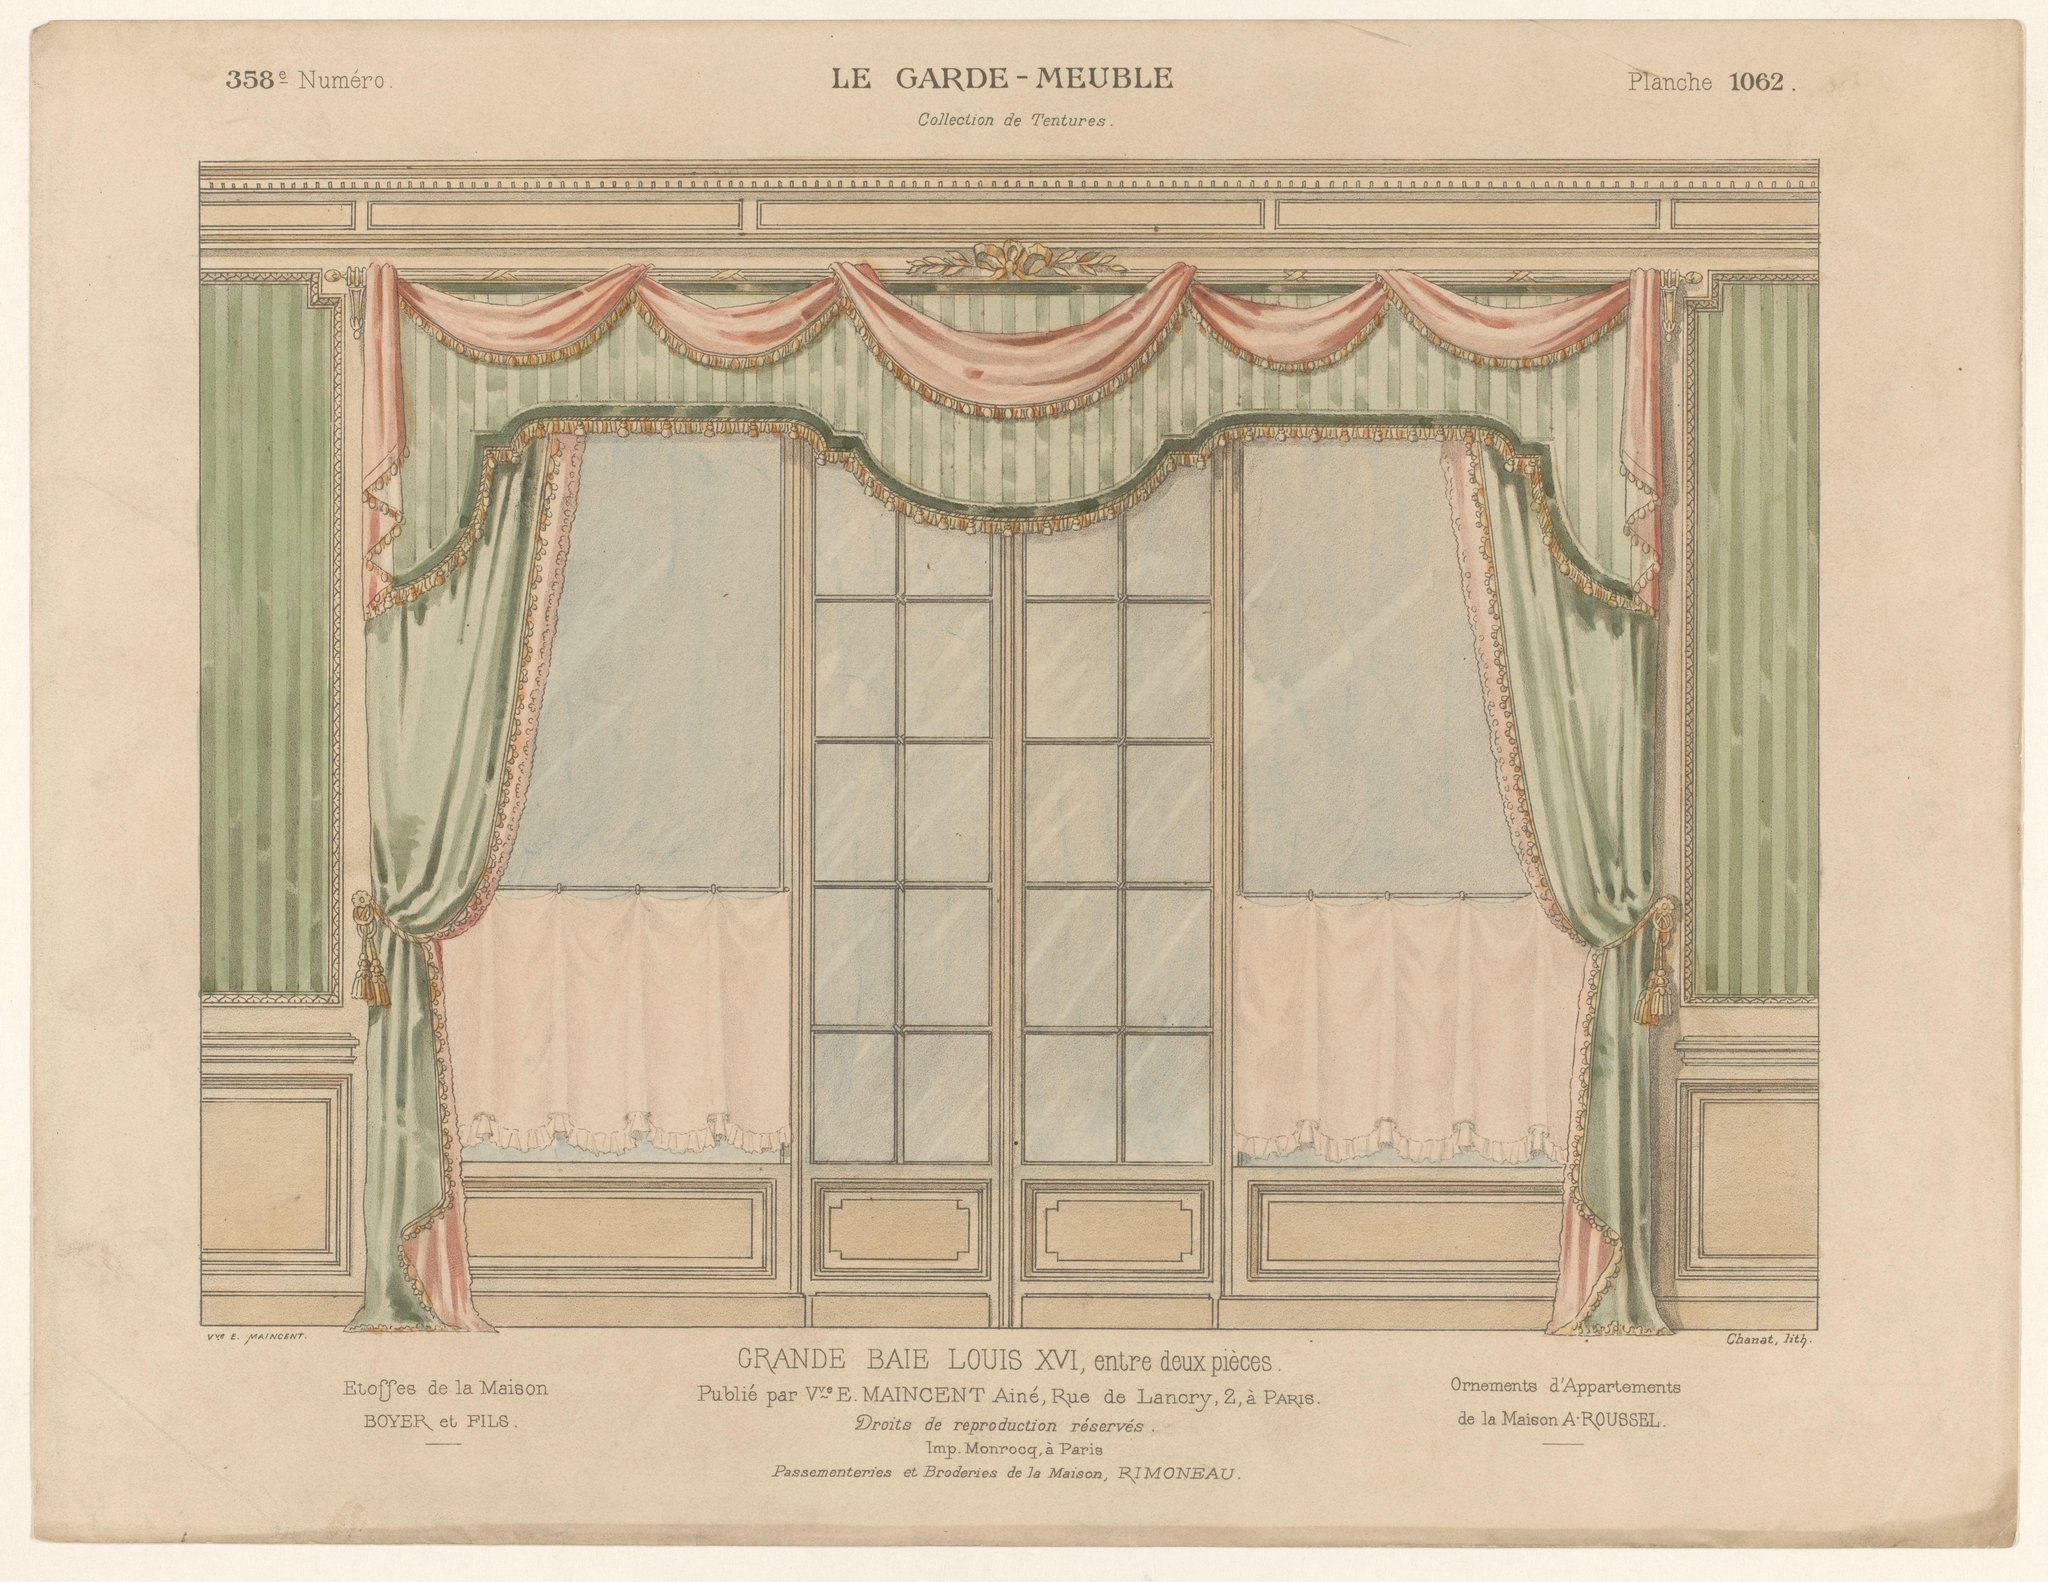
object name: print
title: Le Garde-Meuble / Collection de Tentures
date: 1895-1910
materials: paper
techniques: hand coloring, lithograph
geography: paris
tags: door, hangings and drapery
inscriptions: : ‘Droits de reproduction réservés.’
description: Grote doorgang tussen twee vertrekken met gedrapeerde gordijnen in de Lodewijk XVI-stijl. Prent uit 358e Livraison.